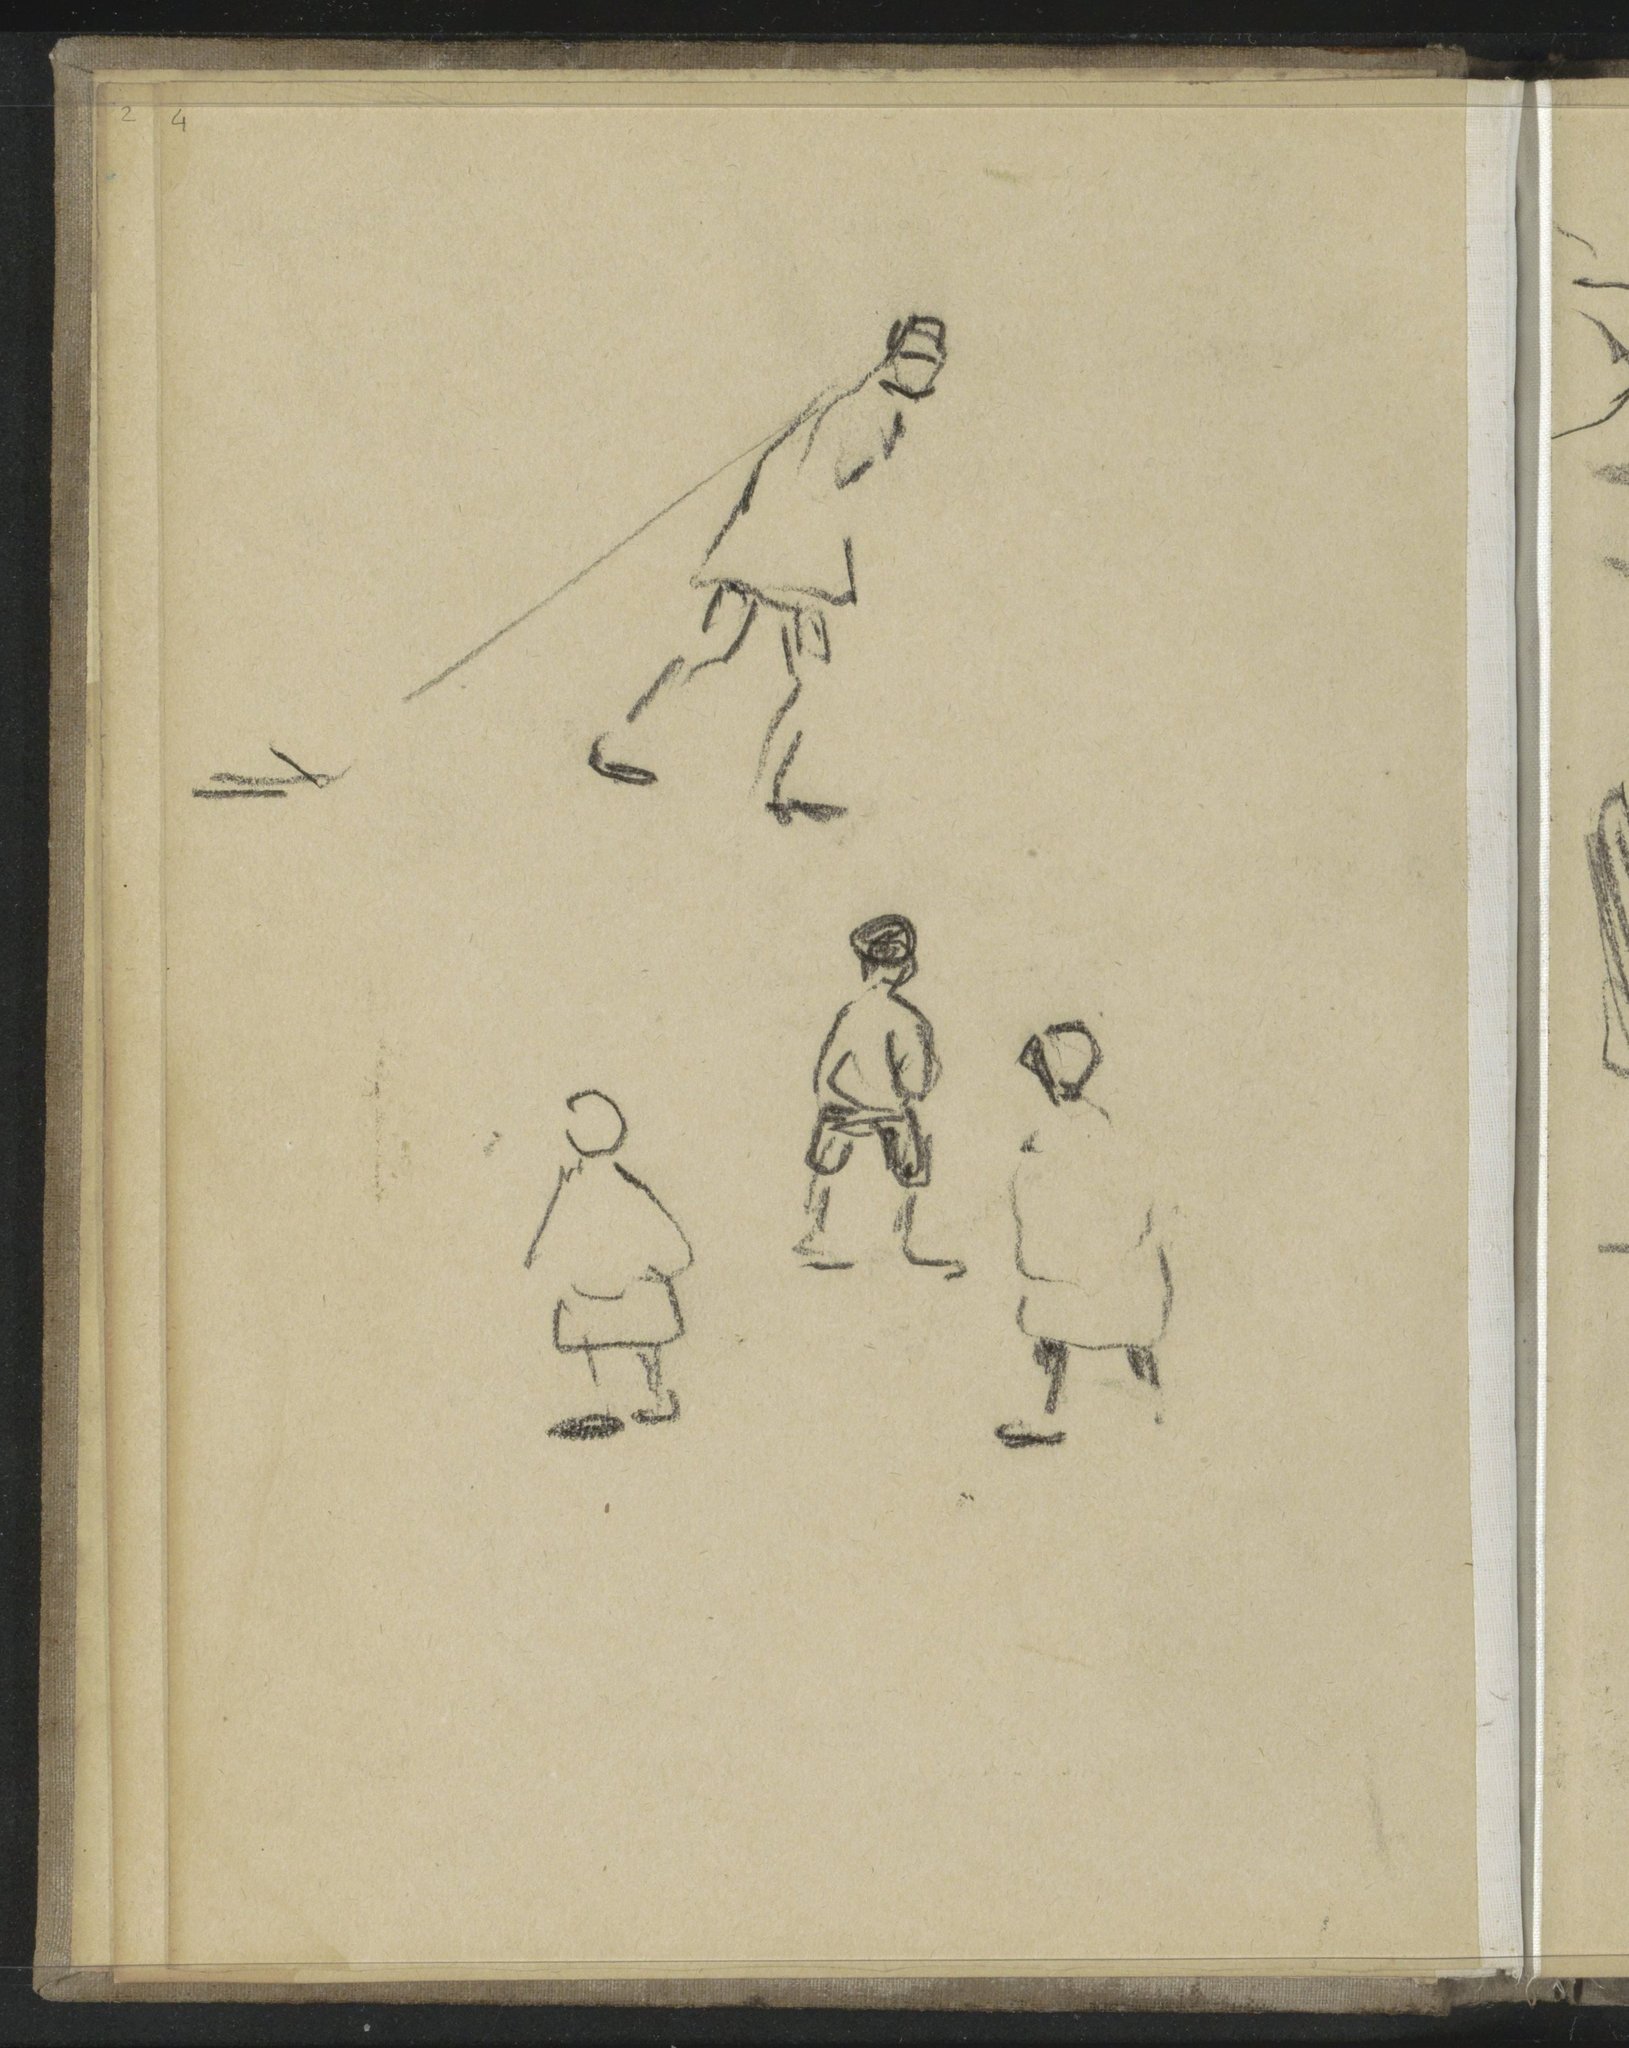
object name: sketchbook leaf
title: Studieblad met drie kinderen en een man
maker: willem witsen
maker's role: draughtsman, painter, print maker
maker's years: 1860-1923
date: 1892-1897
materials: chalk, paper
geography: ede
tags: drawing, pulling something, playing with snow and ice - cc - adult(s) ~ snow and ice, adult man, child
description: De man trekt iets achter zich aan, mogelijk een slee. Pagina 4 uit een schetsboek met 24 bladen.